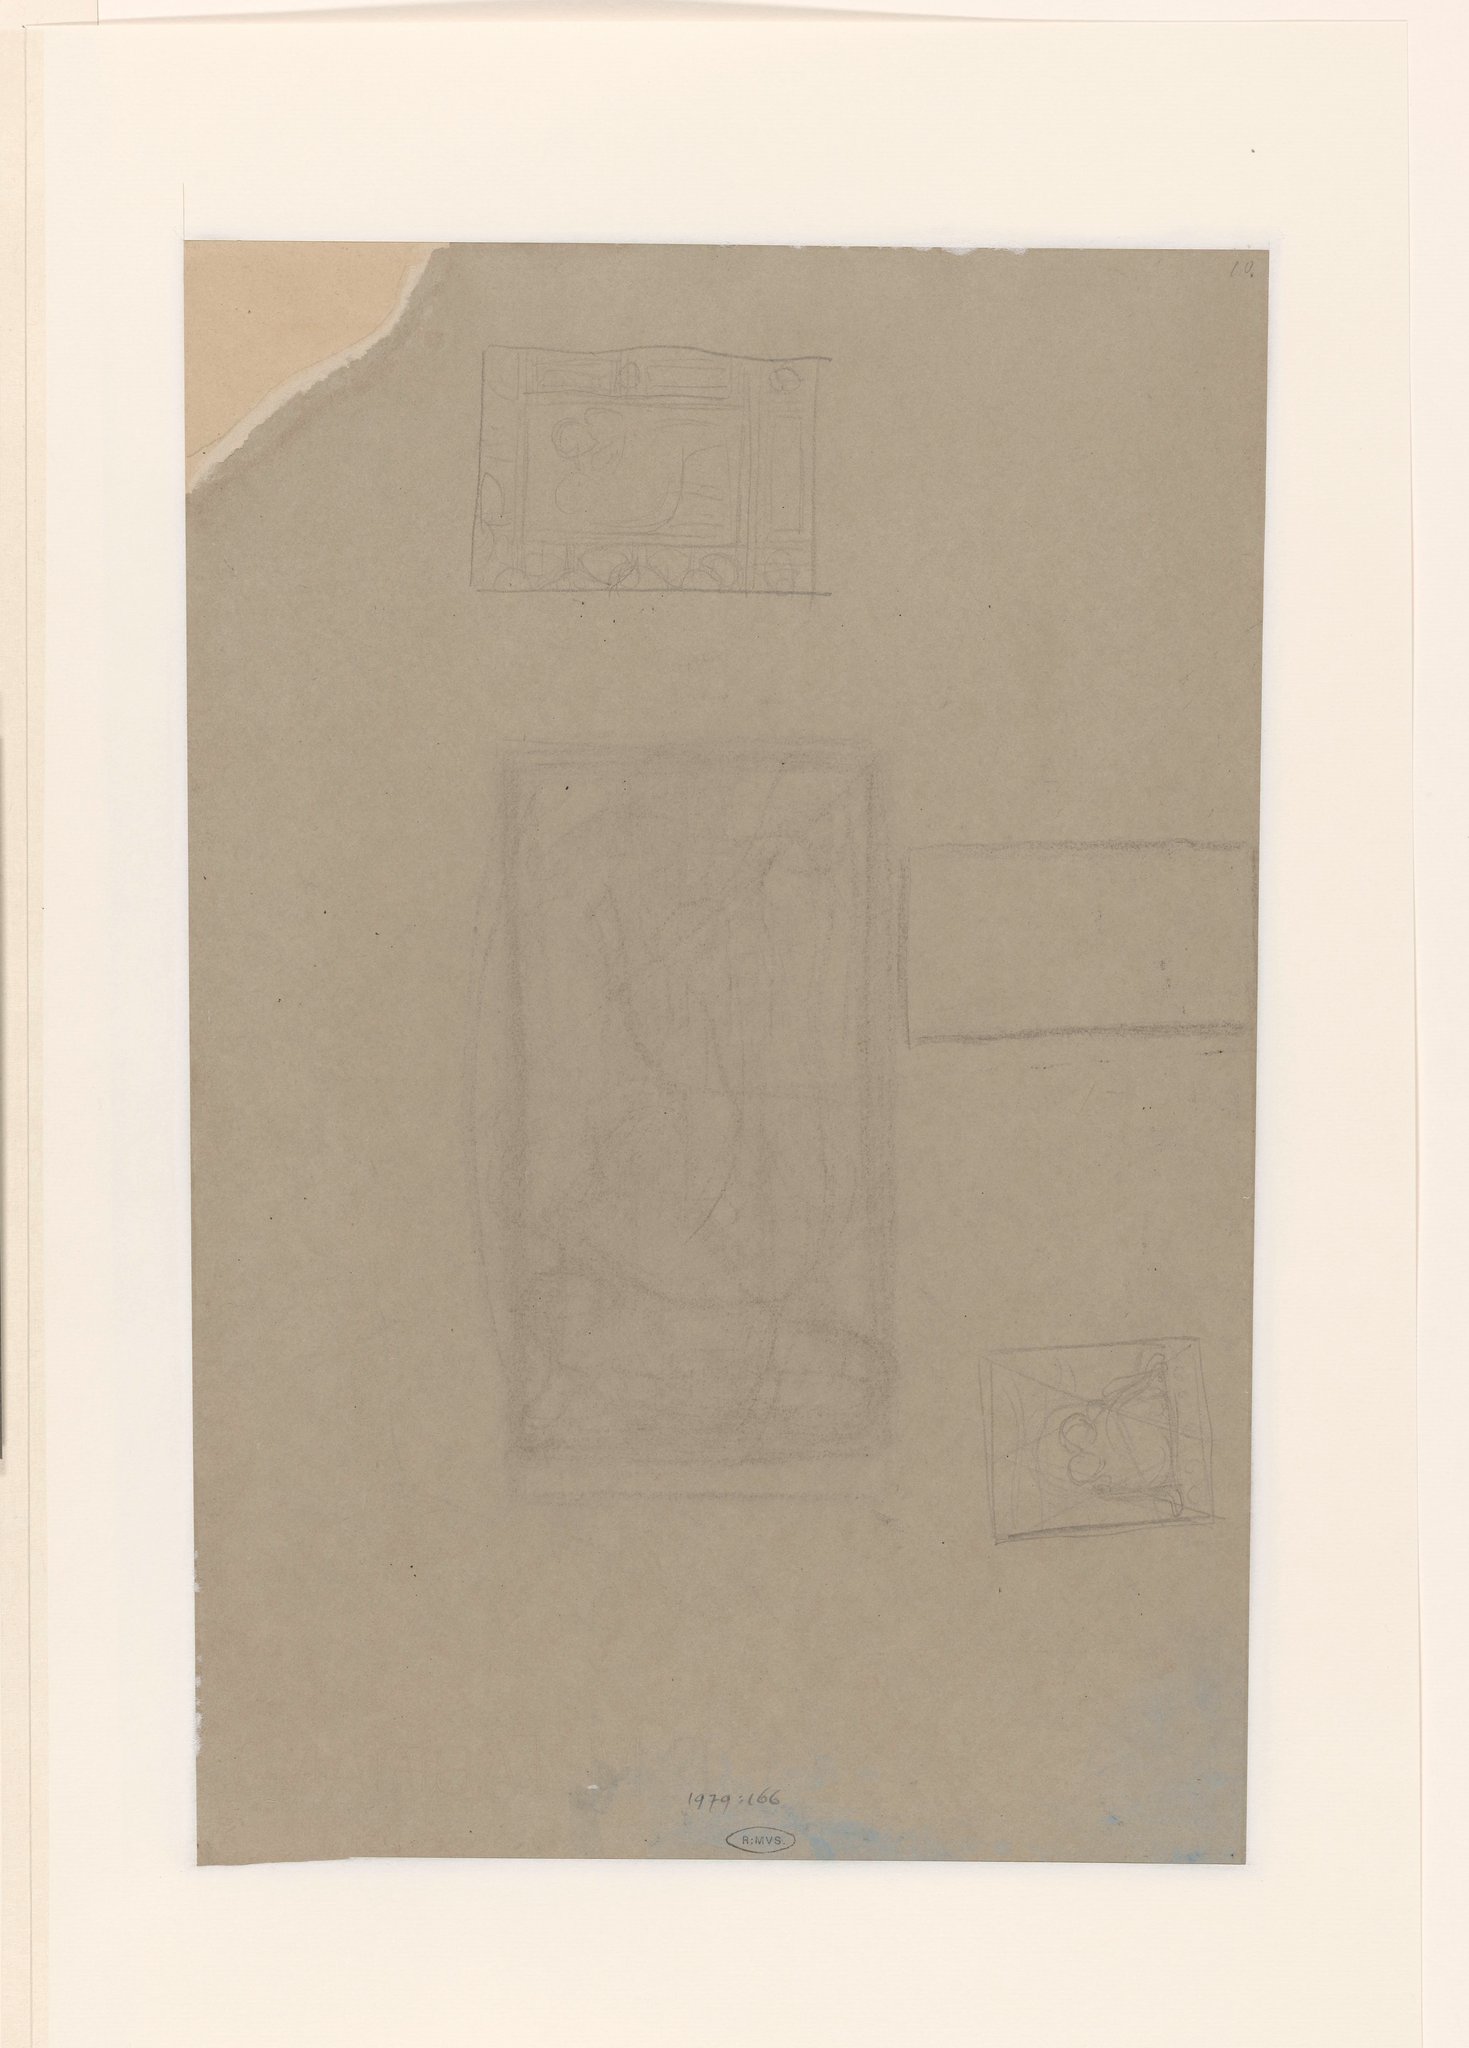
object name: drawing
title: Compositie-studies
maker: richard nicolaüs roland holst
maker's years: 1868-1938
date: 1878-1938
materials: chalk, paper